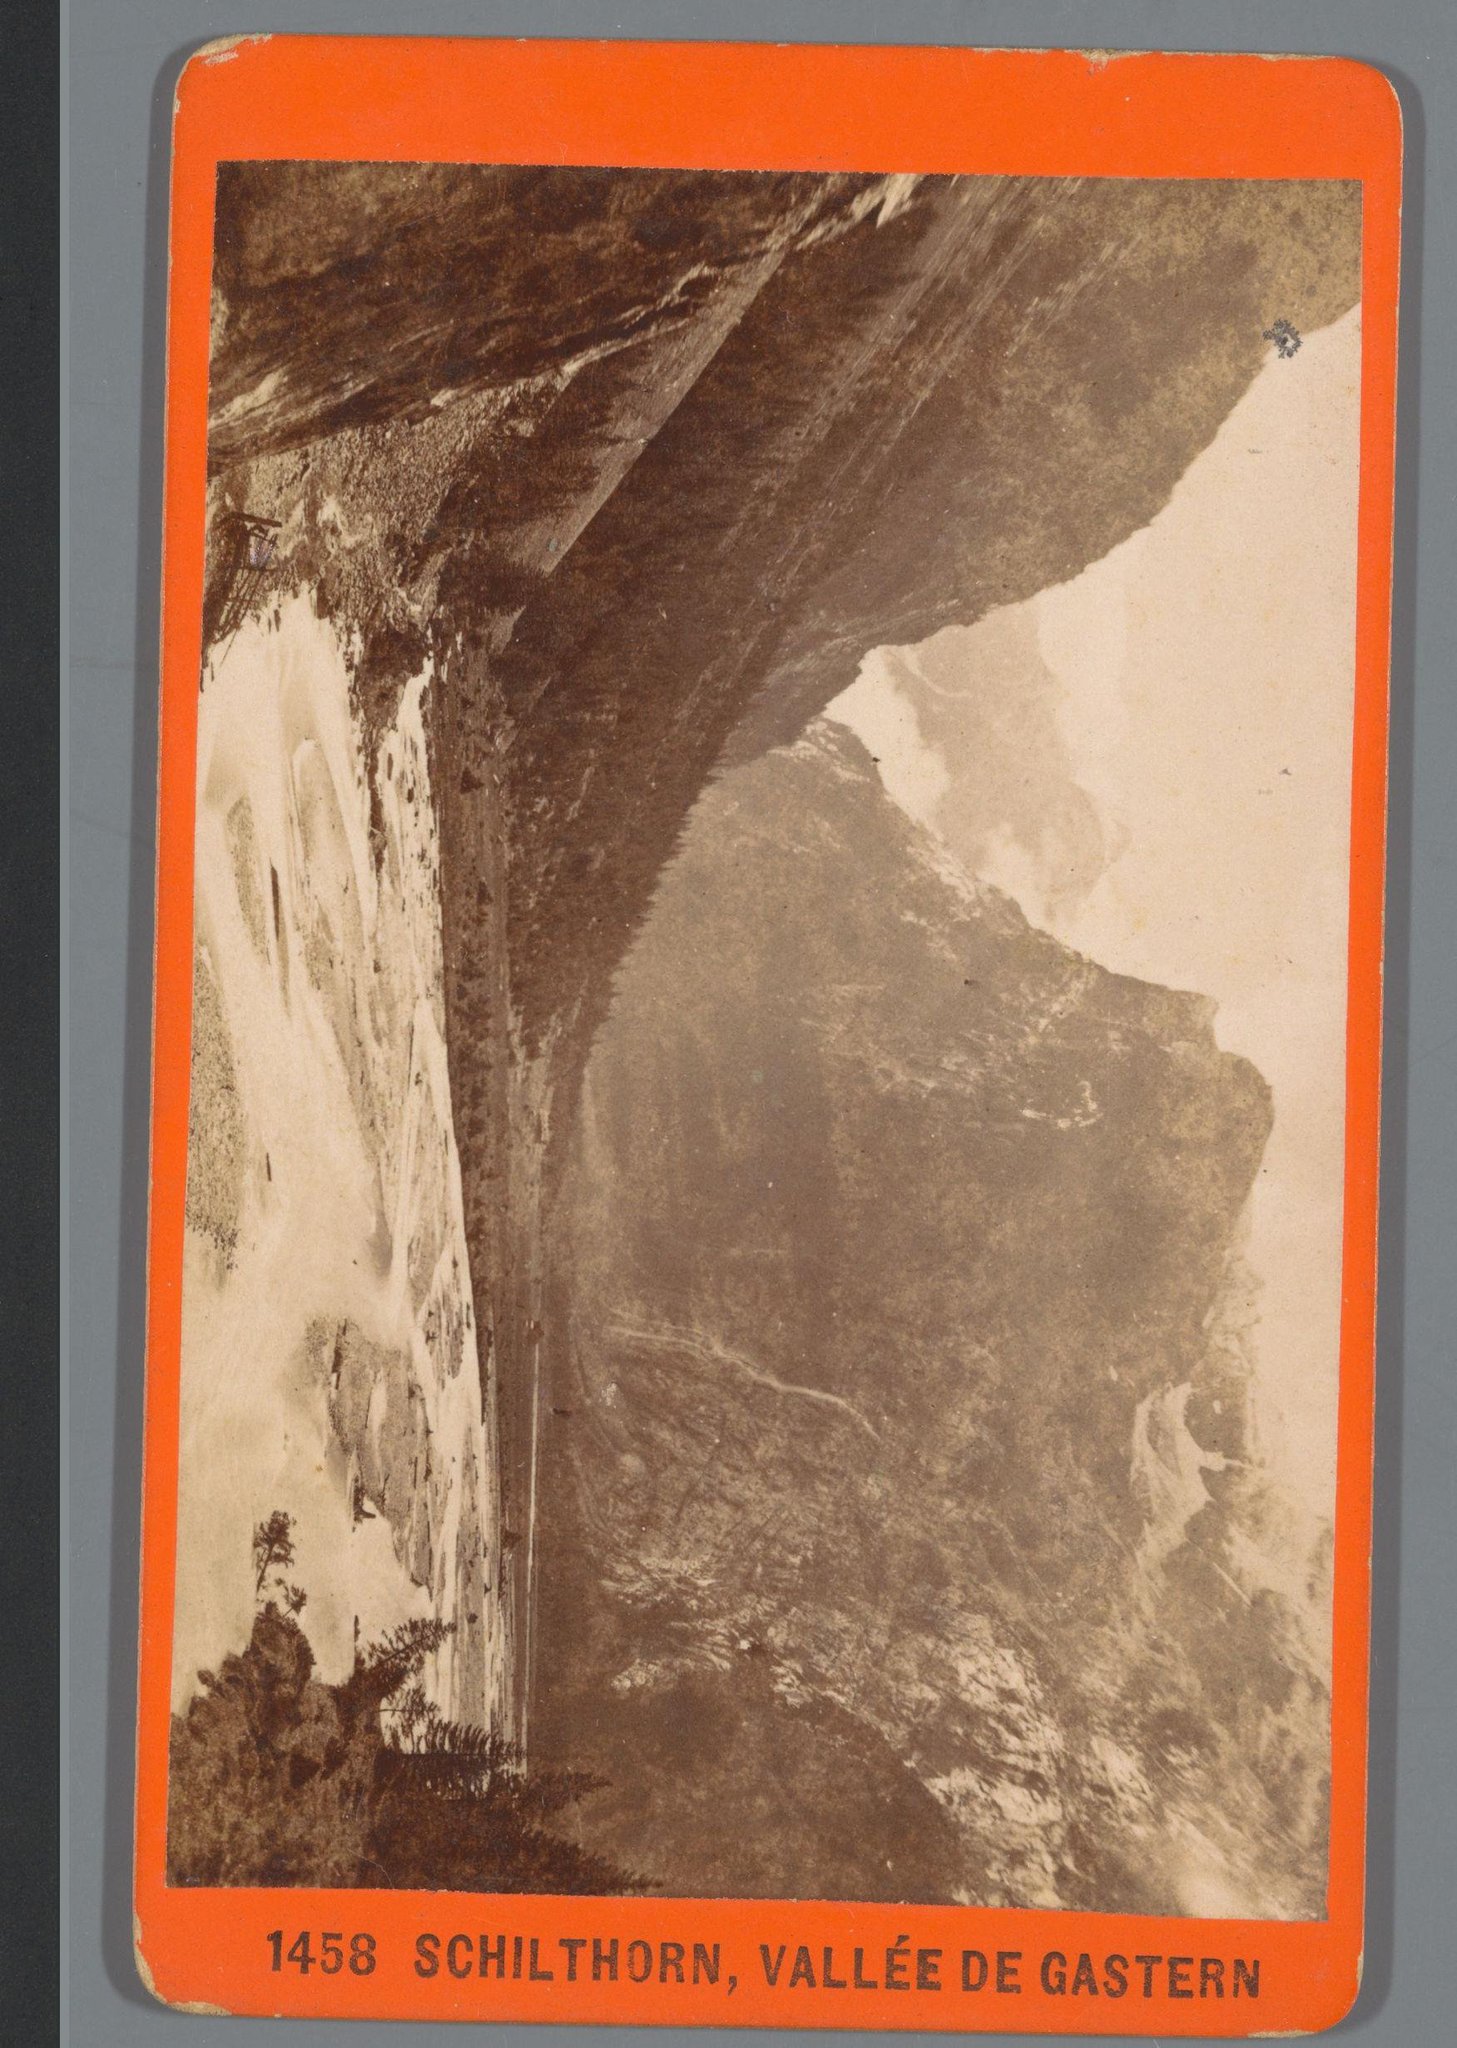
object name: photograph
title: Schilthorn, Vallée de Gastern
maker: arthur gabler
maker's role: publisher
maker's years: 1867-1927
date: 1873-1888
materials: cardboard, paper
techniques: albumen print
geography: berner alpen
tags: river, mountains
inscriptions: inscription: ‘Weltausstellung 1873 Wien/ A. Gabler/ Photographisches Atelier/ Interlaken/ Schweiz.’, number: ‘1458’, inscription: ‘Berner Oberland’